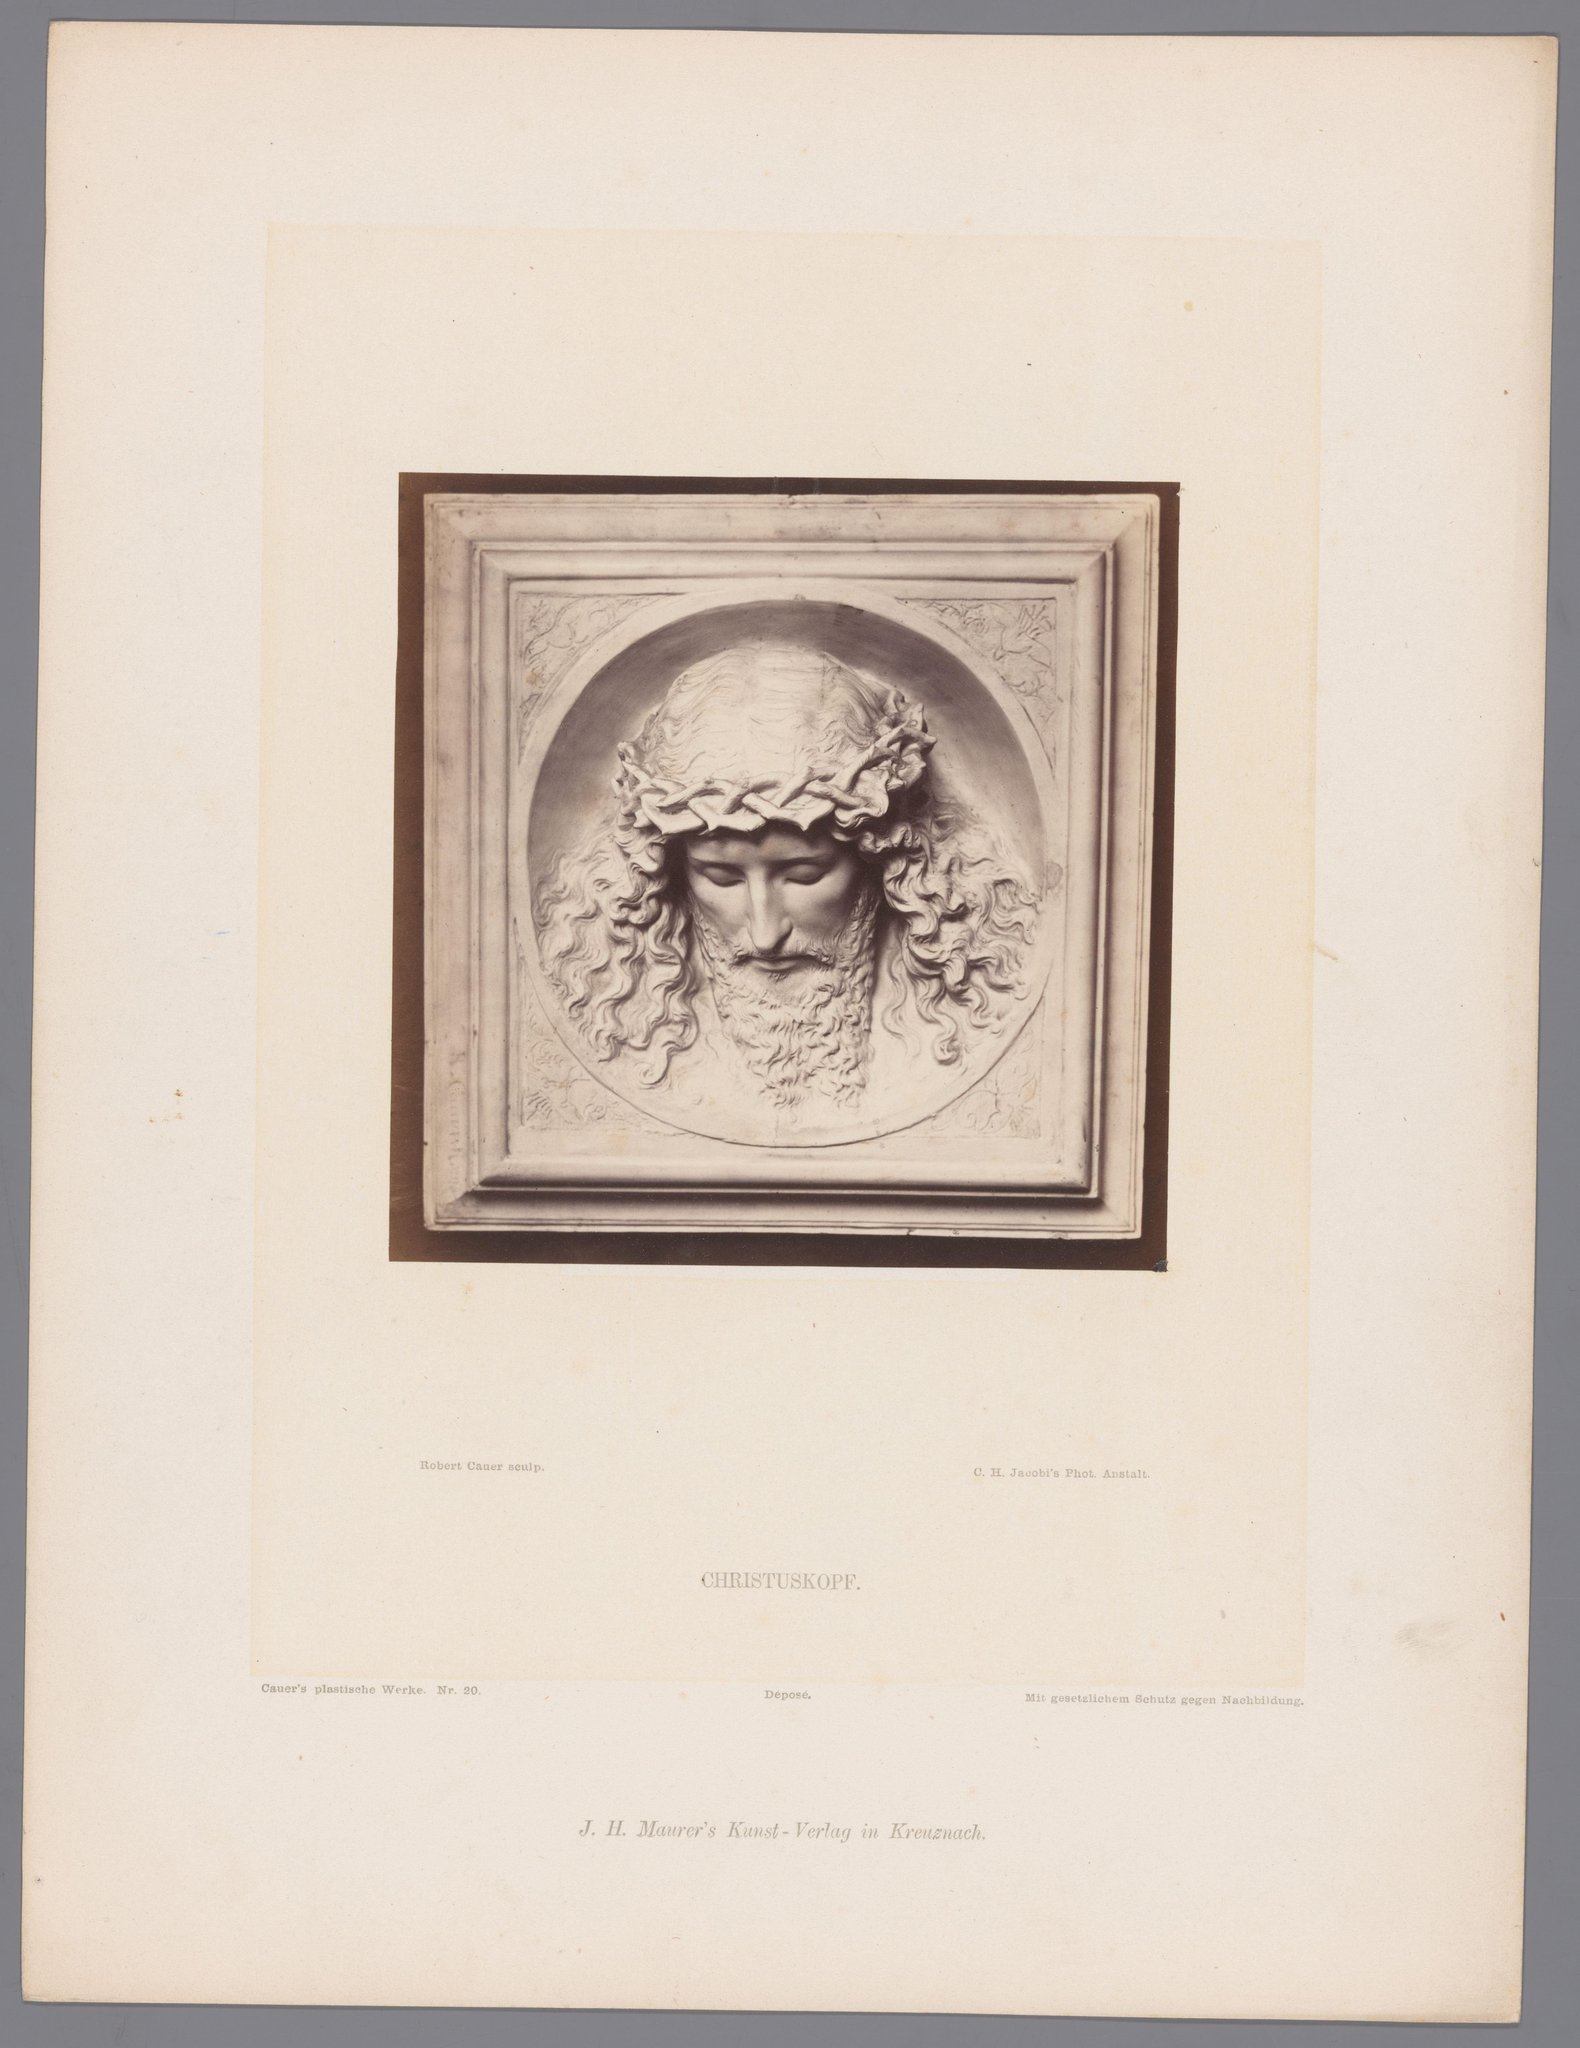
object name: photograph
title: Christuskopf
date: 1850-1900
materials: cardboard, photographic support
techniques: albumen print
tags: christ, sculpture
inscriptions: inscription: ‘Robert Cauer sculp./Cauer's plastische Werke. Nr. 20 Déposé. Mit gesetzlichem Schutz gegen Nachbildung’